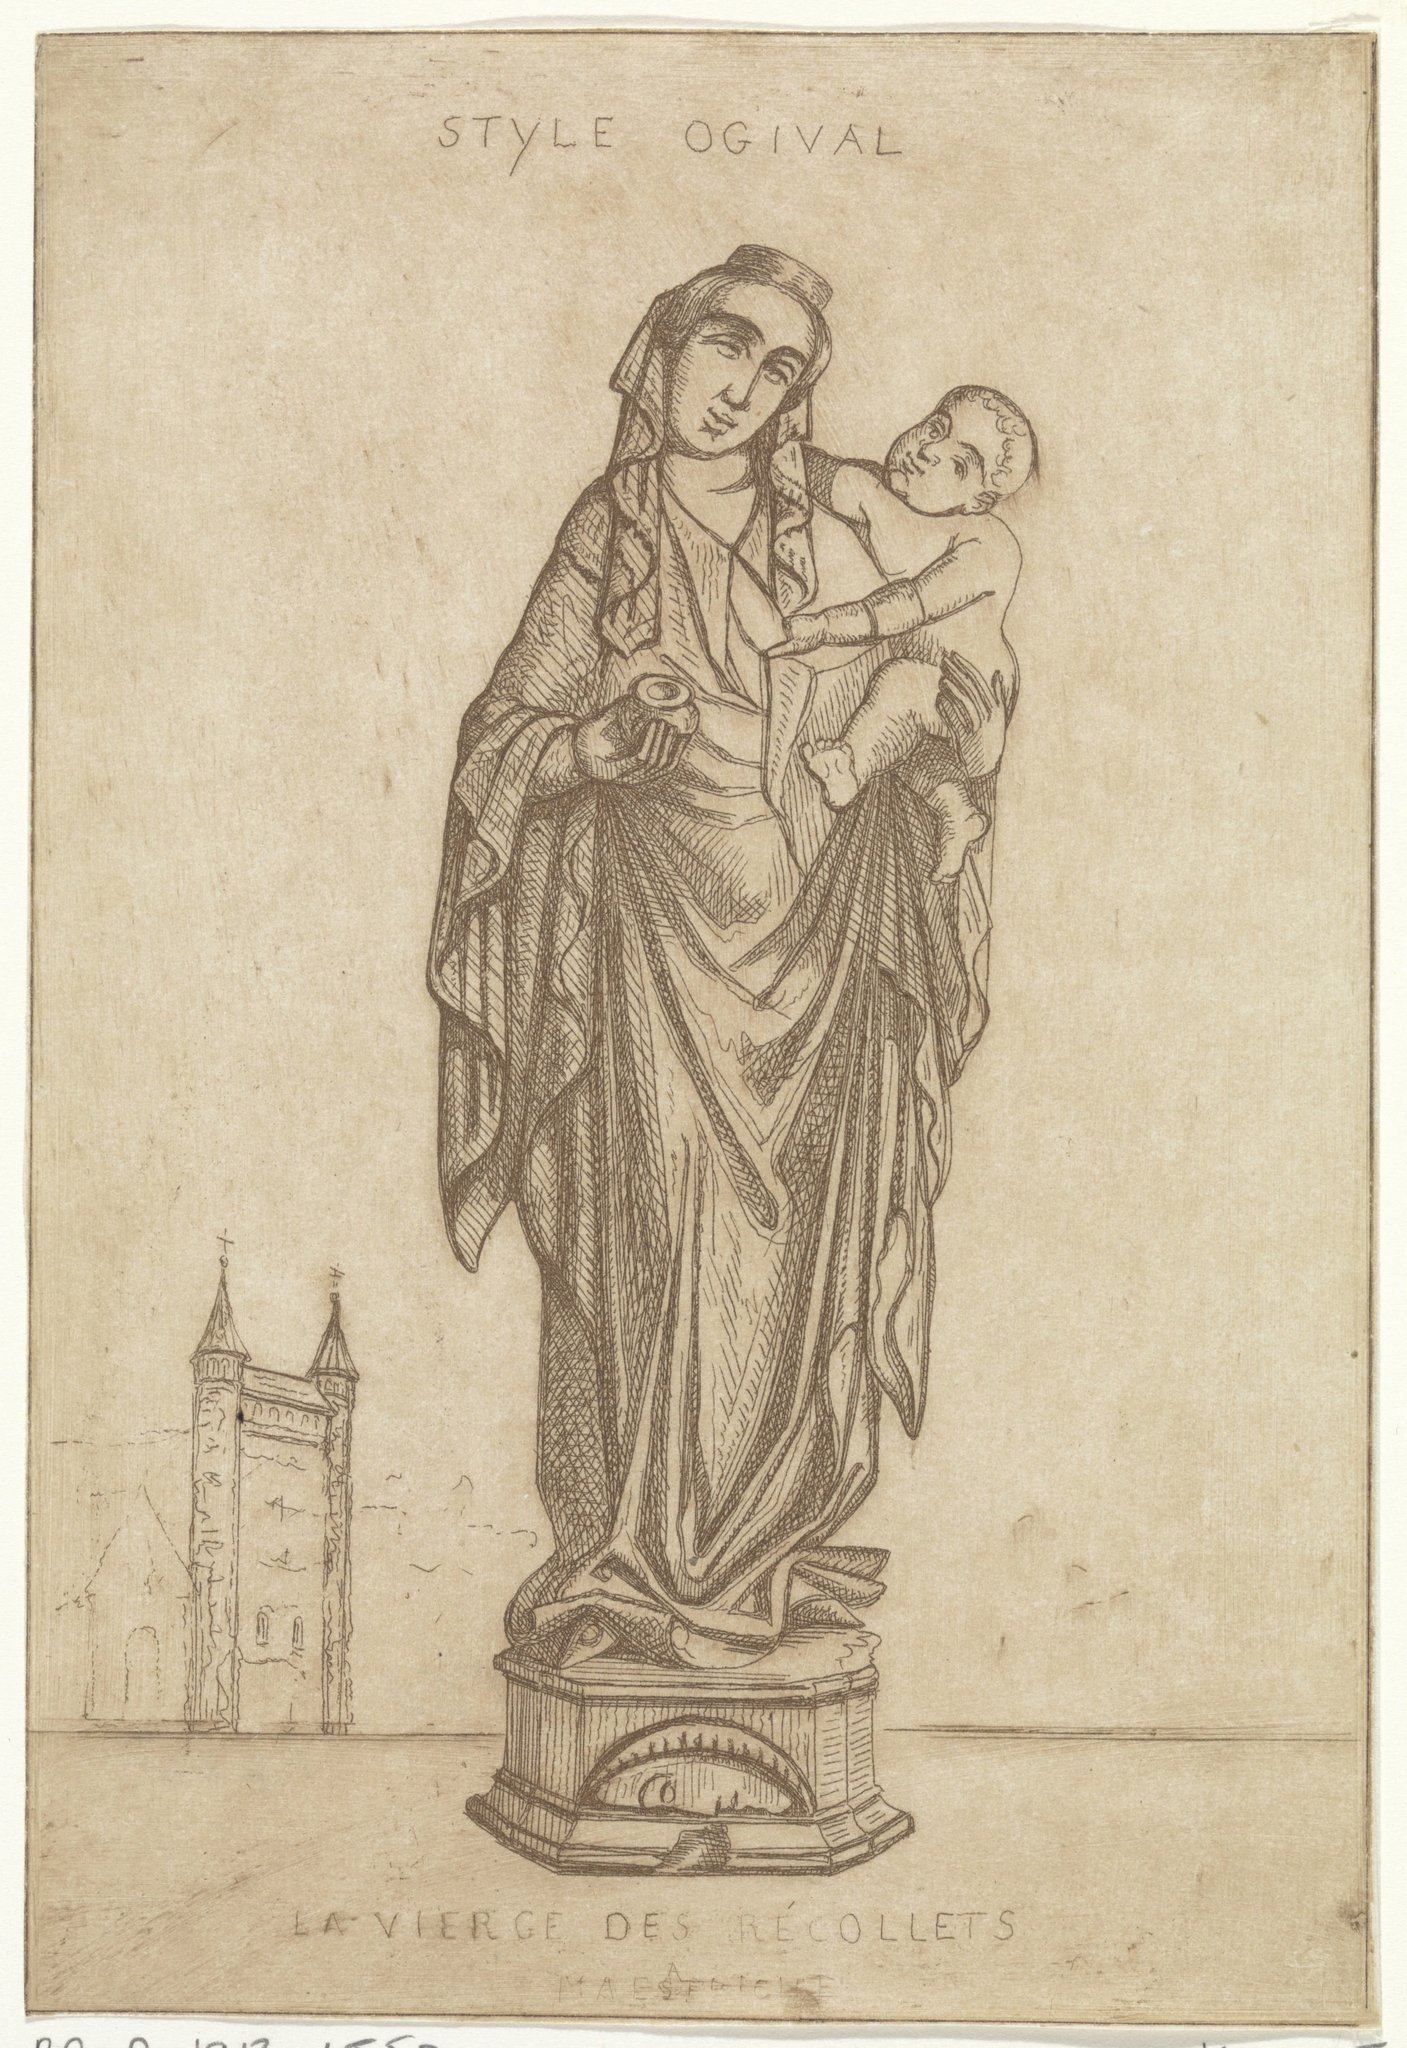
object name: print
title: Maria, Sterre der Zee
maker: arnoud schaepkens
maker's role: print maker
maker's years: 1816-1904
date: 1831-1904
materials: paper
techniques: drypoint, etching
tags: madonna: i.e. mary with the christ-child, monument, statue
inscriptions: collector's mark: Lugt 2228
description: Op de achtergrond de Onze-Lieve-Vrouwe-Basiliek en de De Mérodekapel, de locatie van de sculptuur.